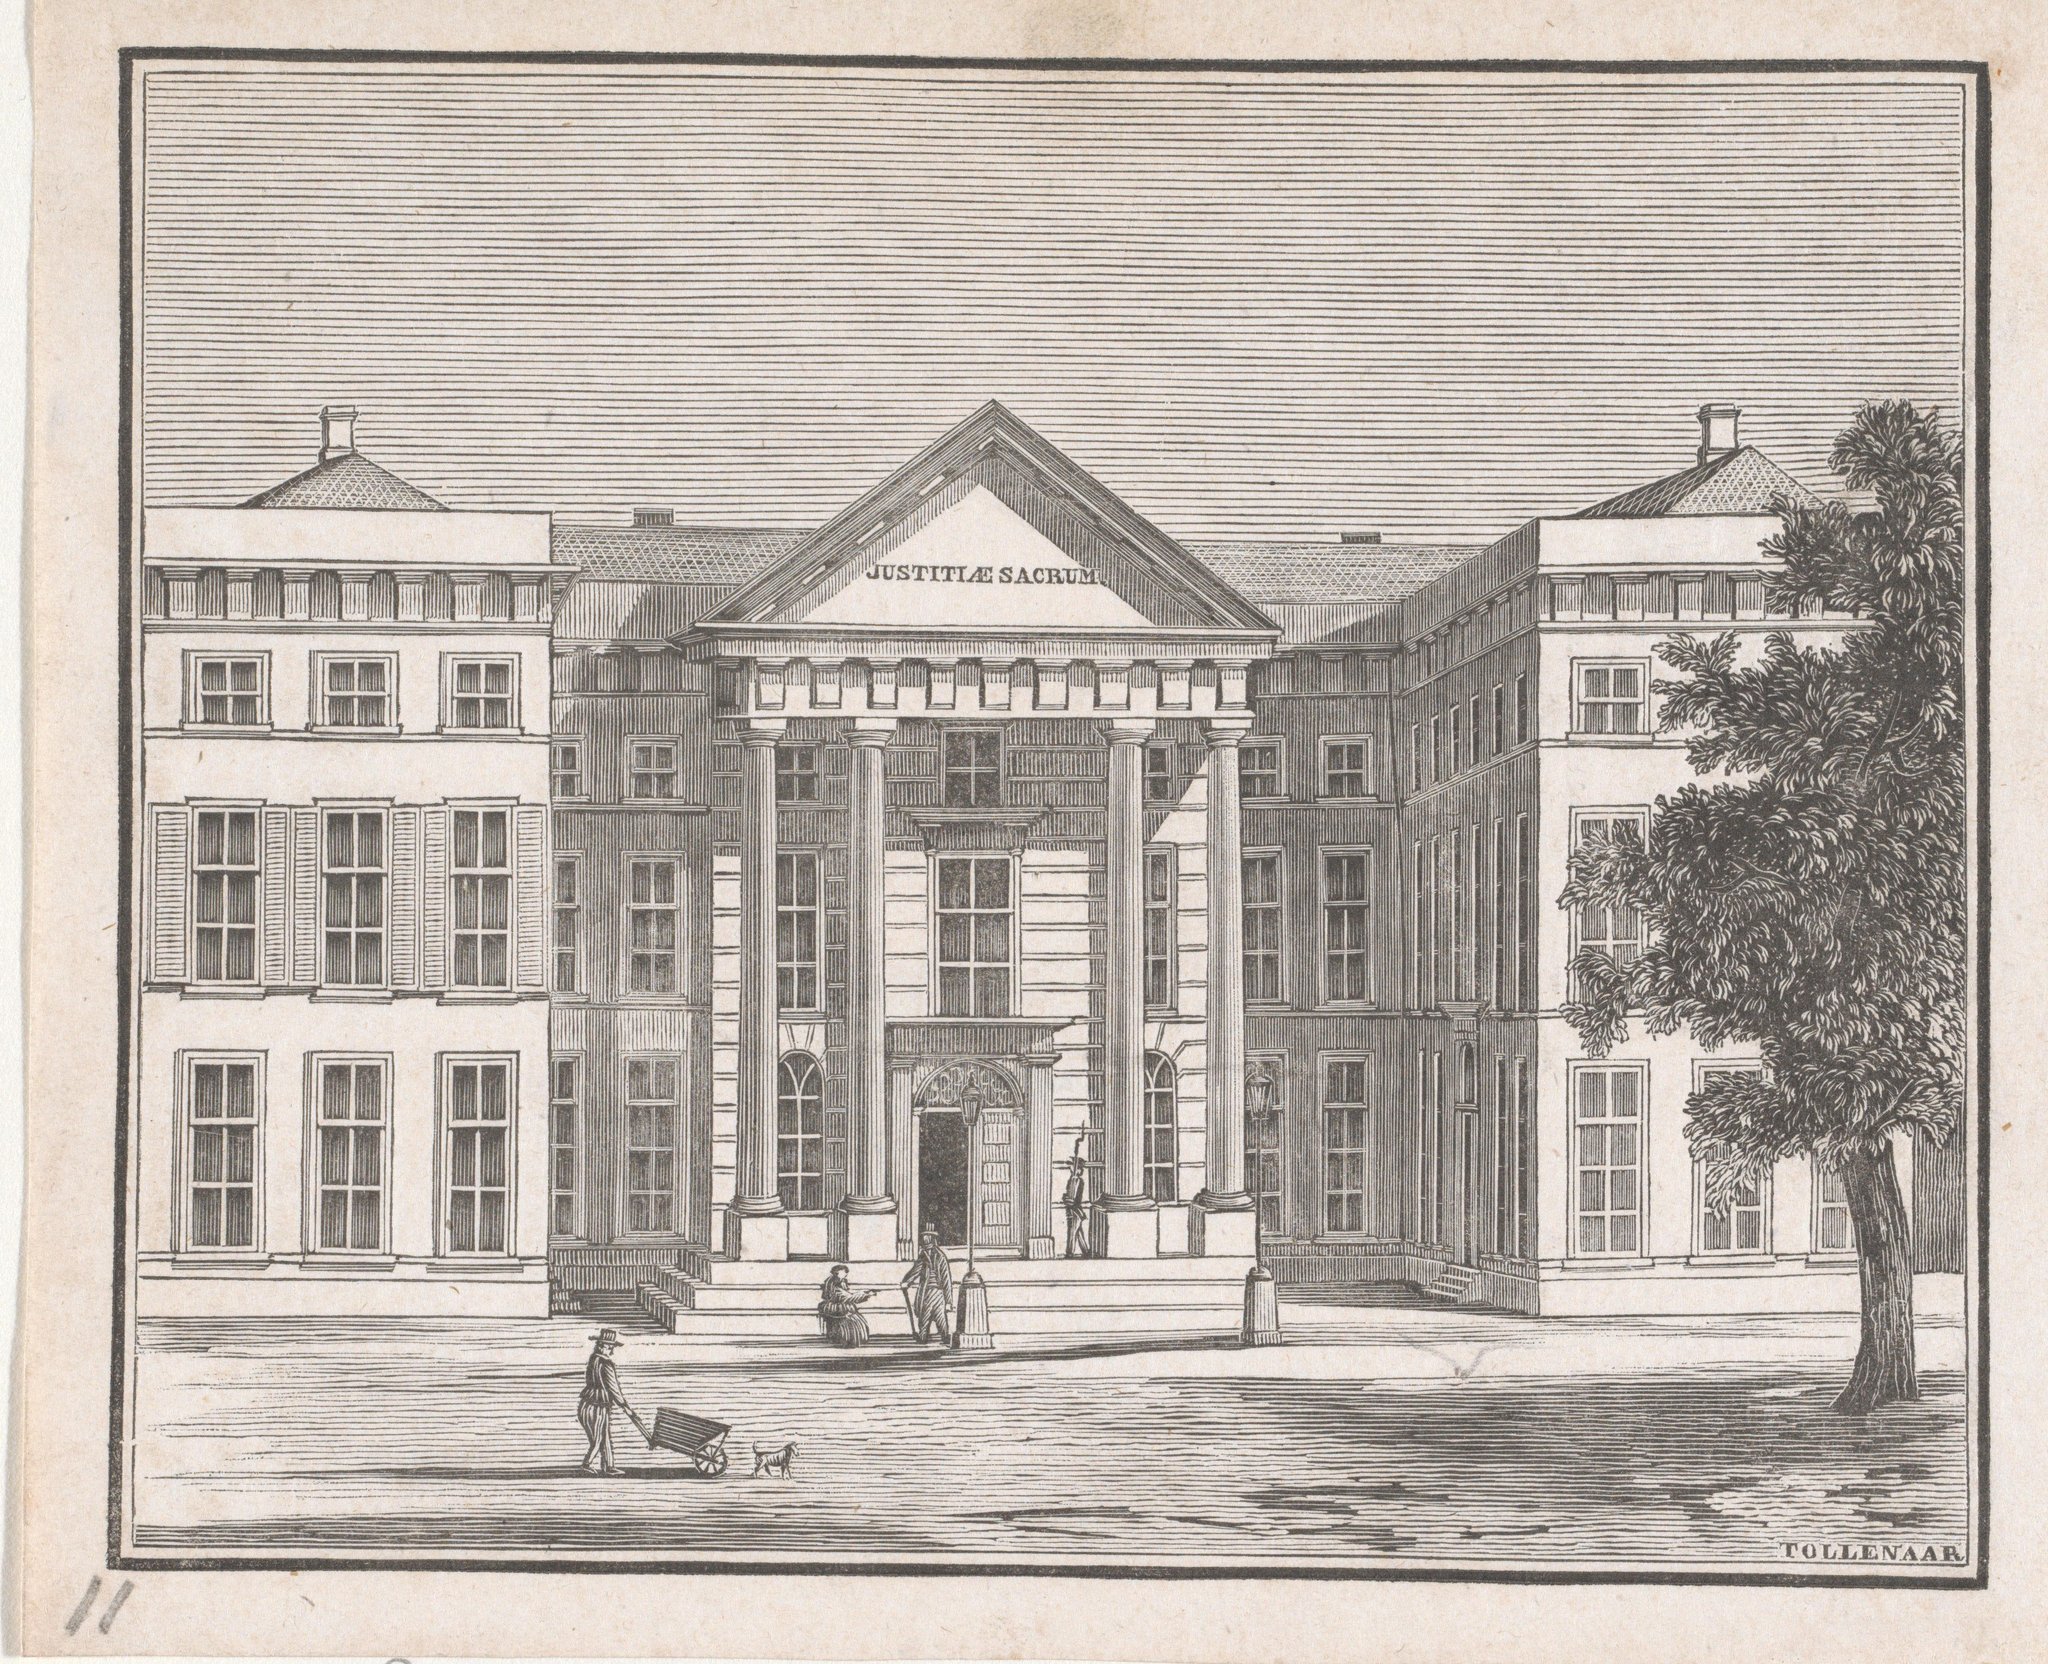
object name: print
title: Paleis van Justitie aan de Grote Markt te Anhem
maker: antonie vink tollenaar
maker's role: print maker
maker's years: 1805-1875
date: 1815-1875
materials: paper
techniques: engraving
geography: netherlands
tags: court building, square, place, circus, etc. (+ city(-scape) with figures, staffage)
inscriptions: collector's mark: Lugt 2228